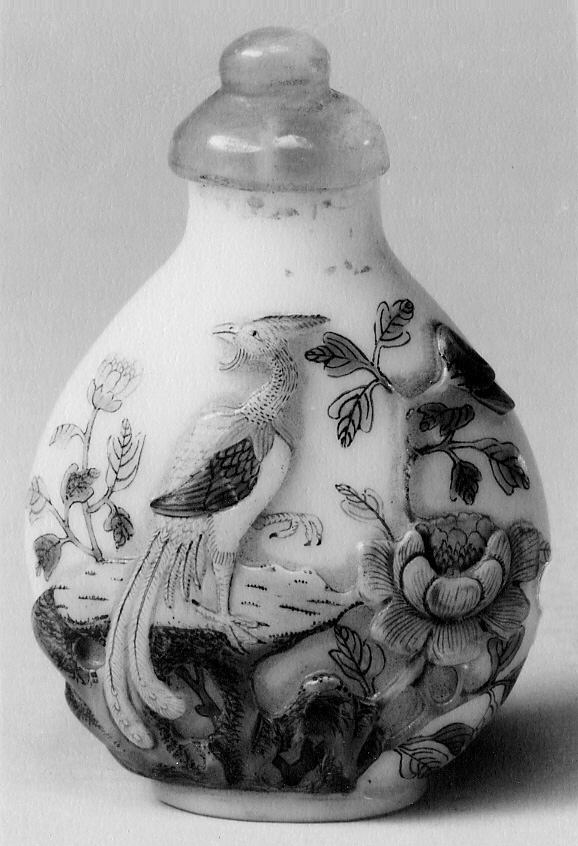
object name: snuff bottle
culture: chinese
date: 1644-1911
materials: glass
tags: birds,flowers